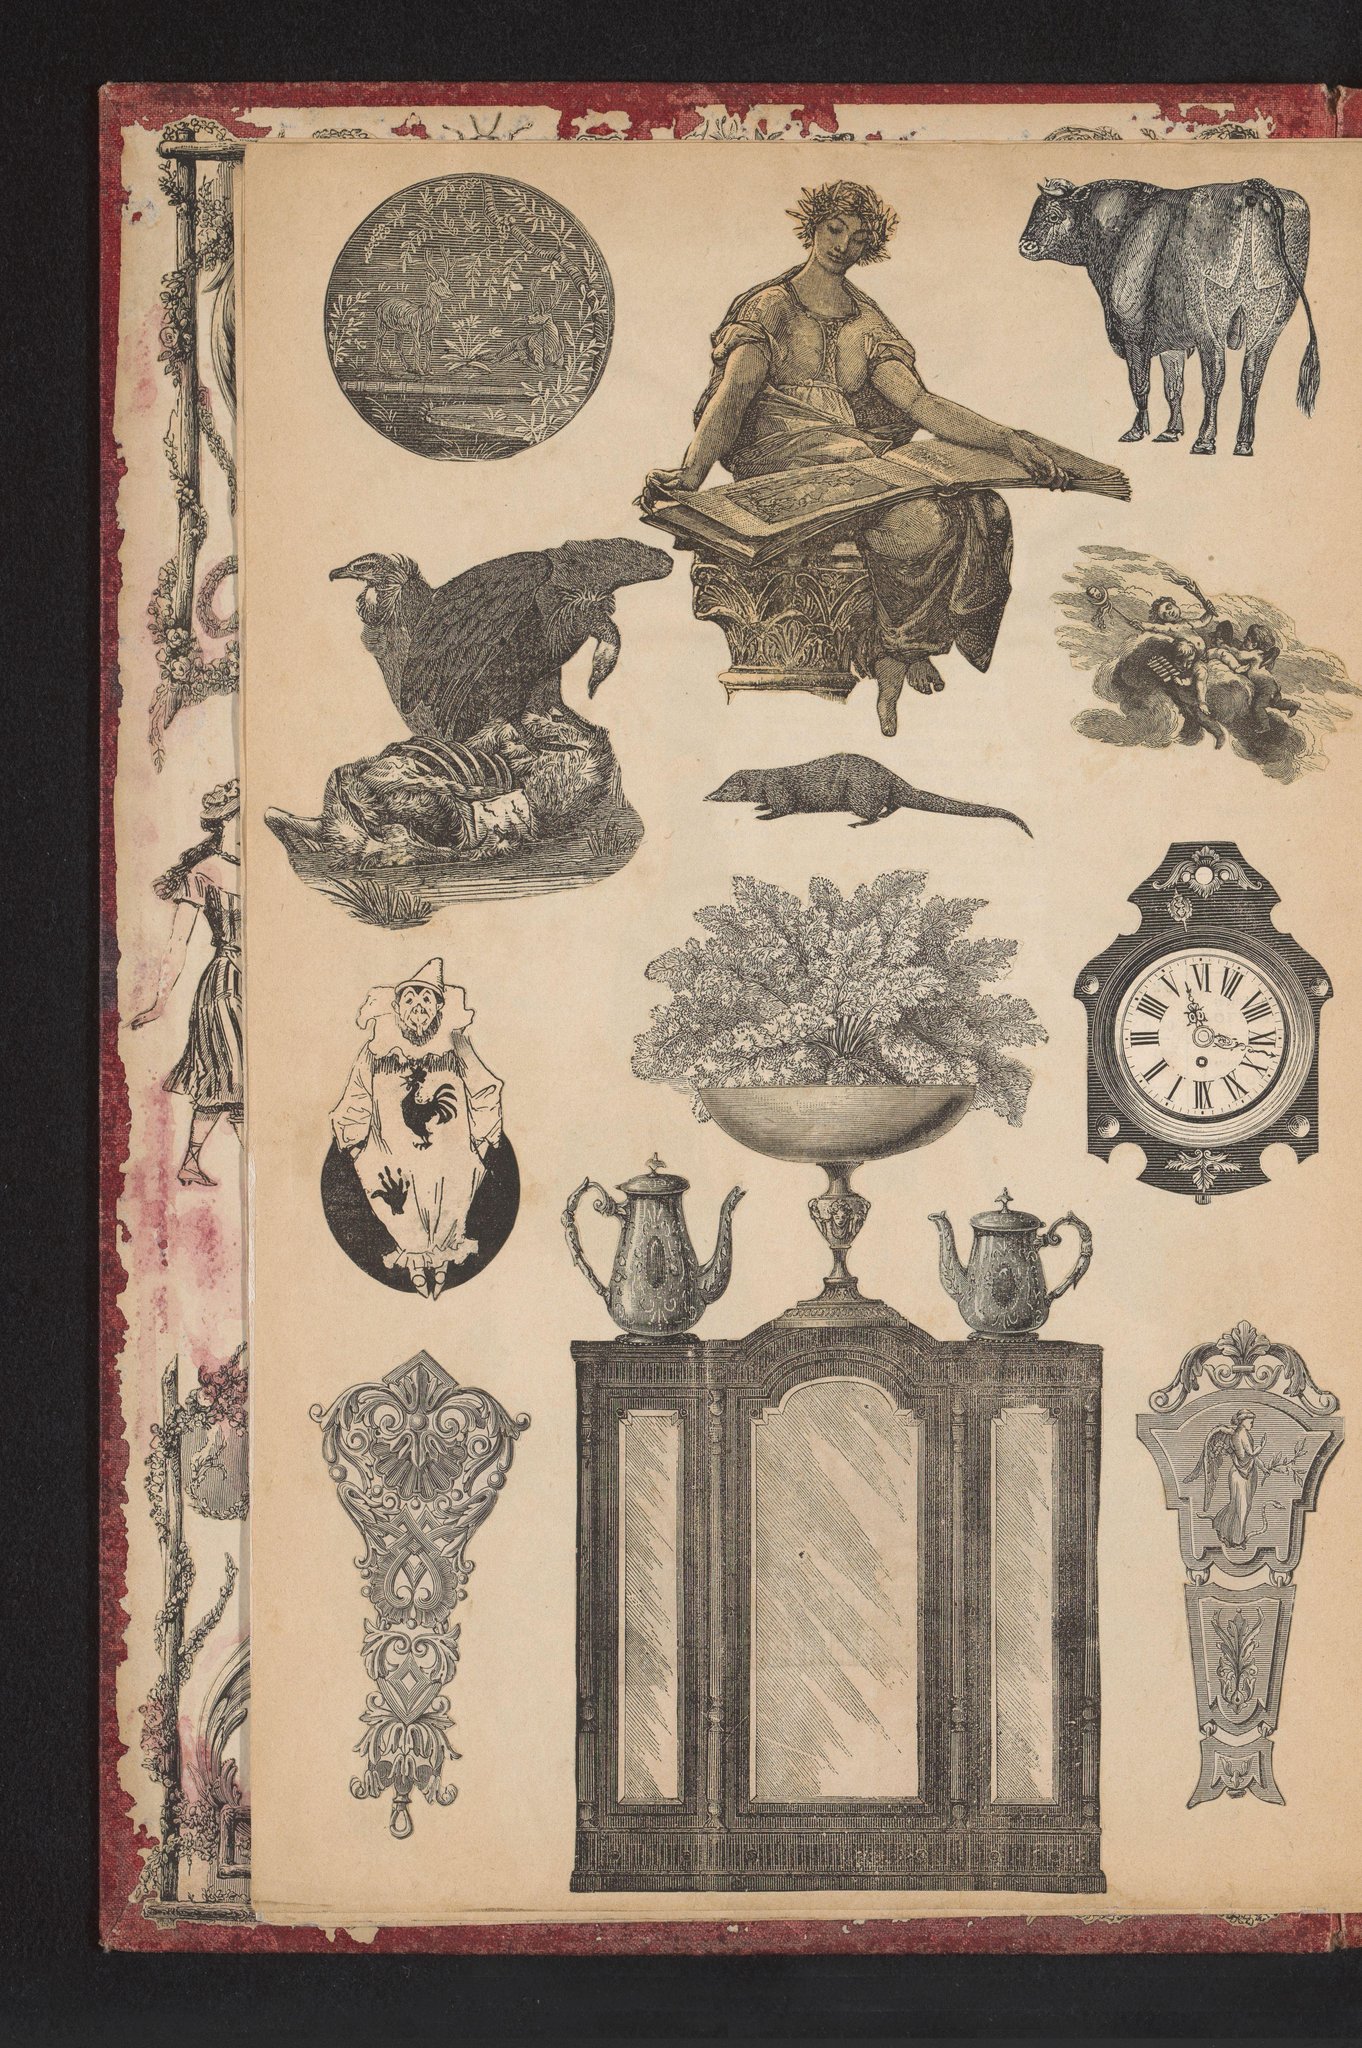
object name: collage visual work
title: Collage van uitgeknipte prenten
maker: Anonymous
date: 1870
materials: paper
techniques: engraving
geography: paris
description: Collage van uitgeknipte prenten. Onderdeel van een album met 32 bladen, aan beide zijden beplakt met uitgeknipte prenten, vermoedelijk afkomstig uit 19e-eeuwse tijdschiften.